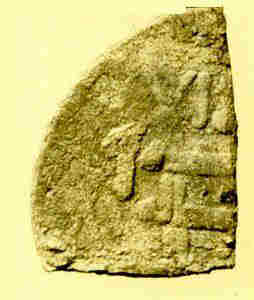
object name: coin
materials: silver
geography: iran